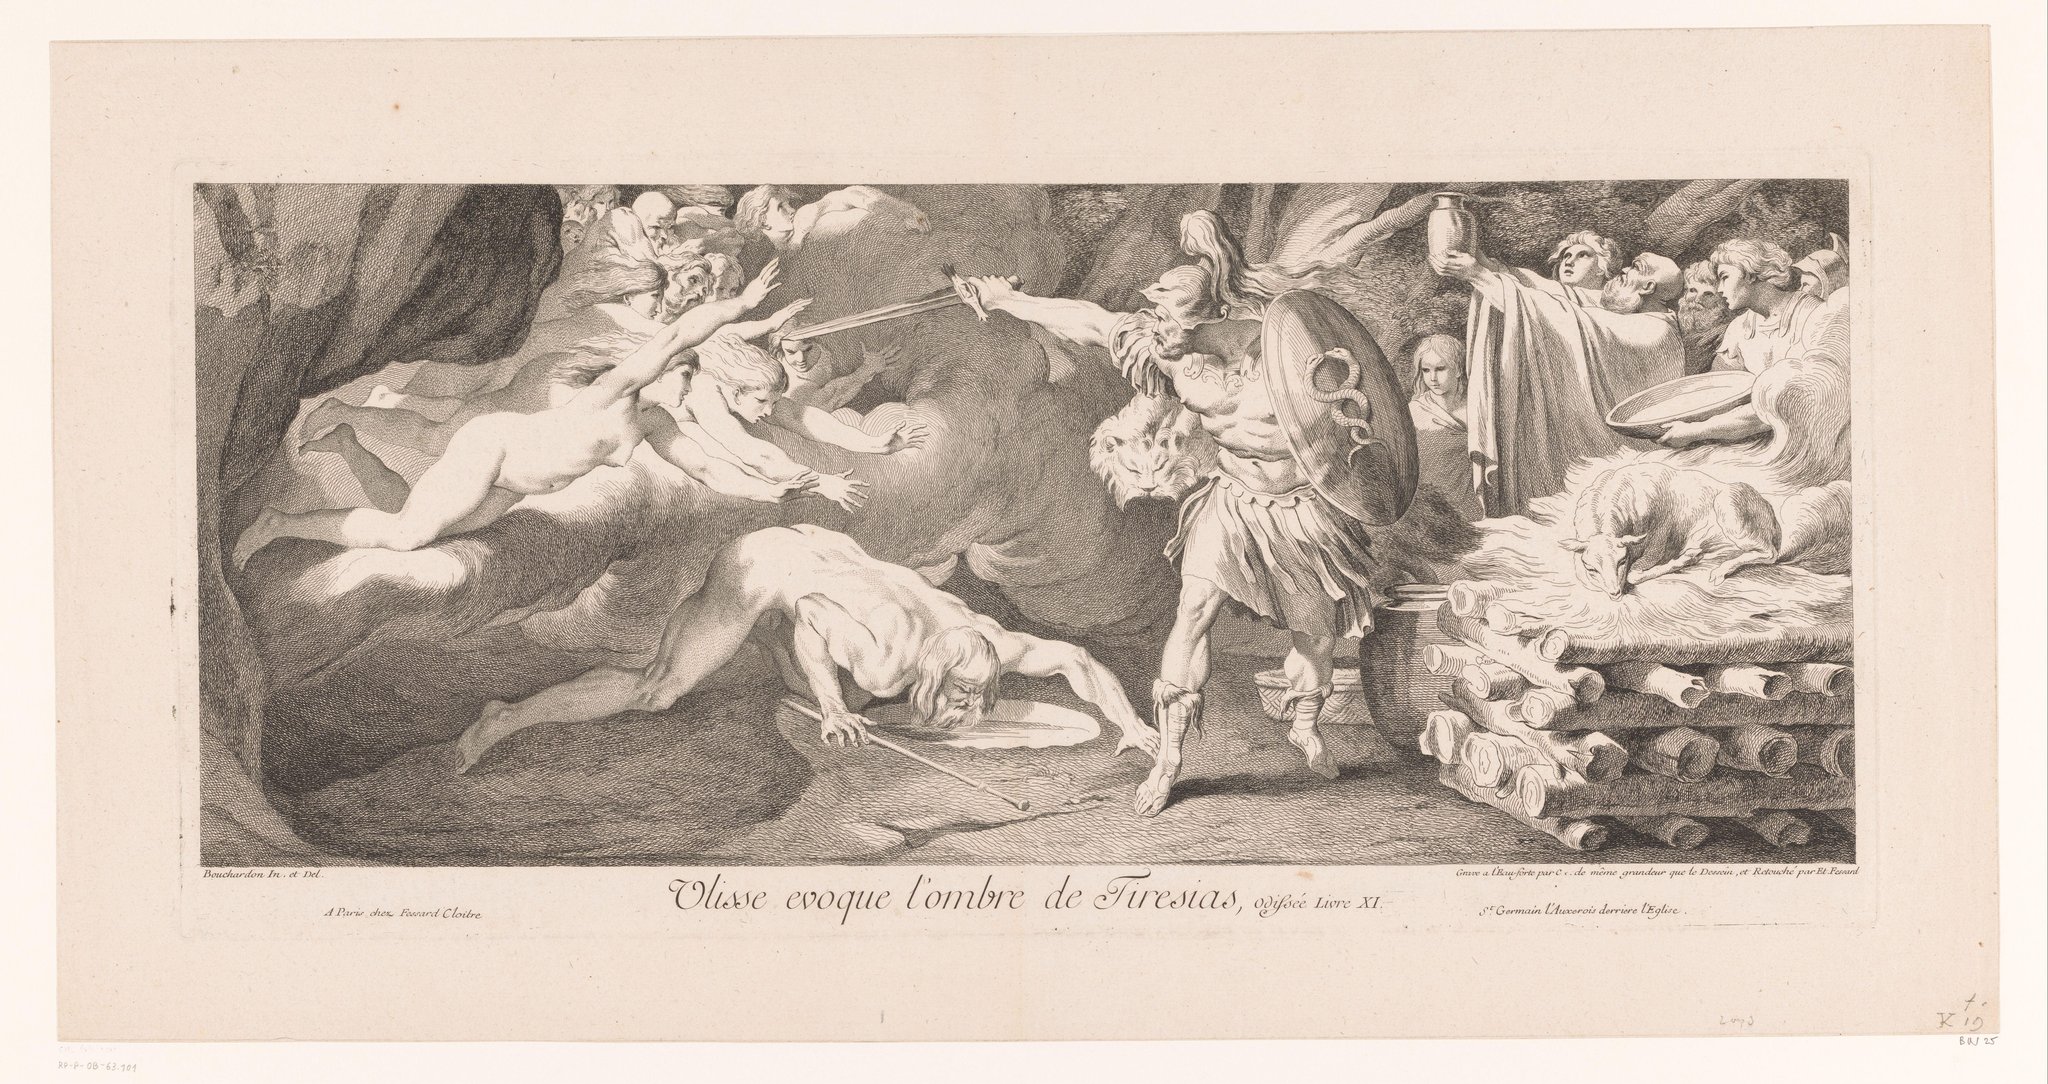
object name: print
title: Olisse evoque l'ombre de Tiresias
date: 1730-1740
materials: paper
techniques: engraving, etching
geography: paris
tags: ulysses and the ghost of tiresias, who tells him about the future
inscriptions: watermark, collector's mark: Lugt 240